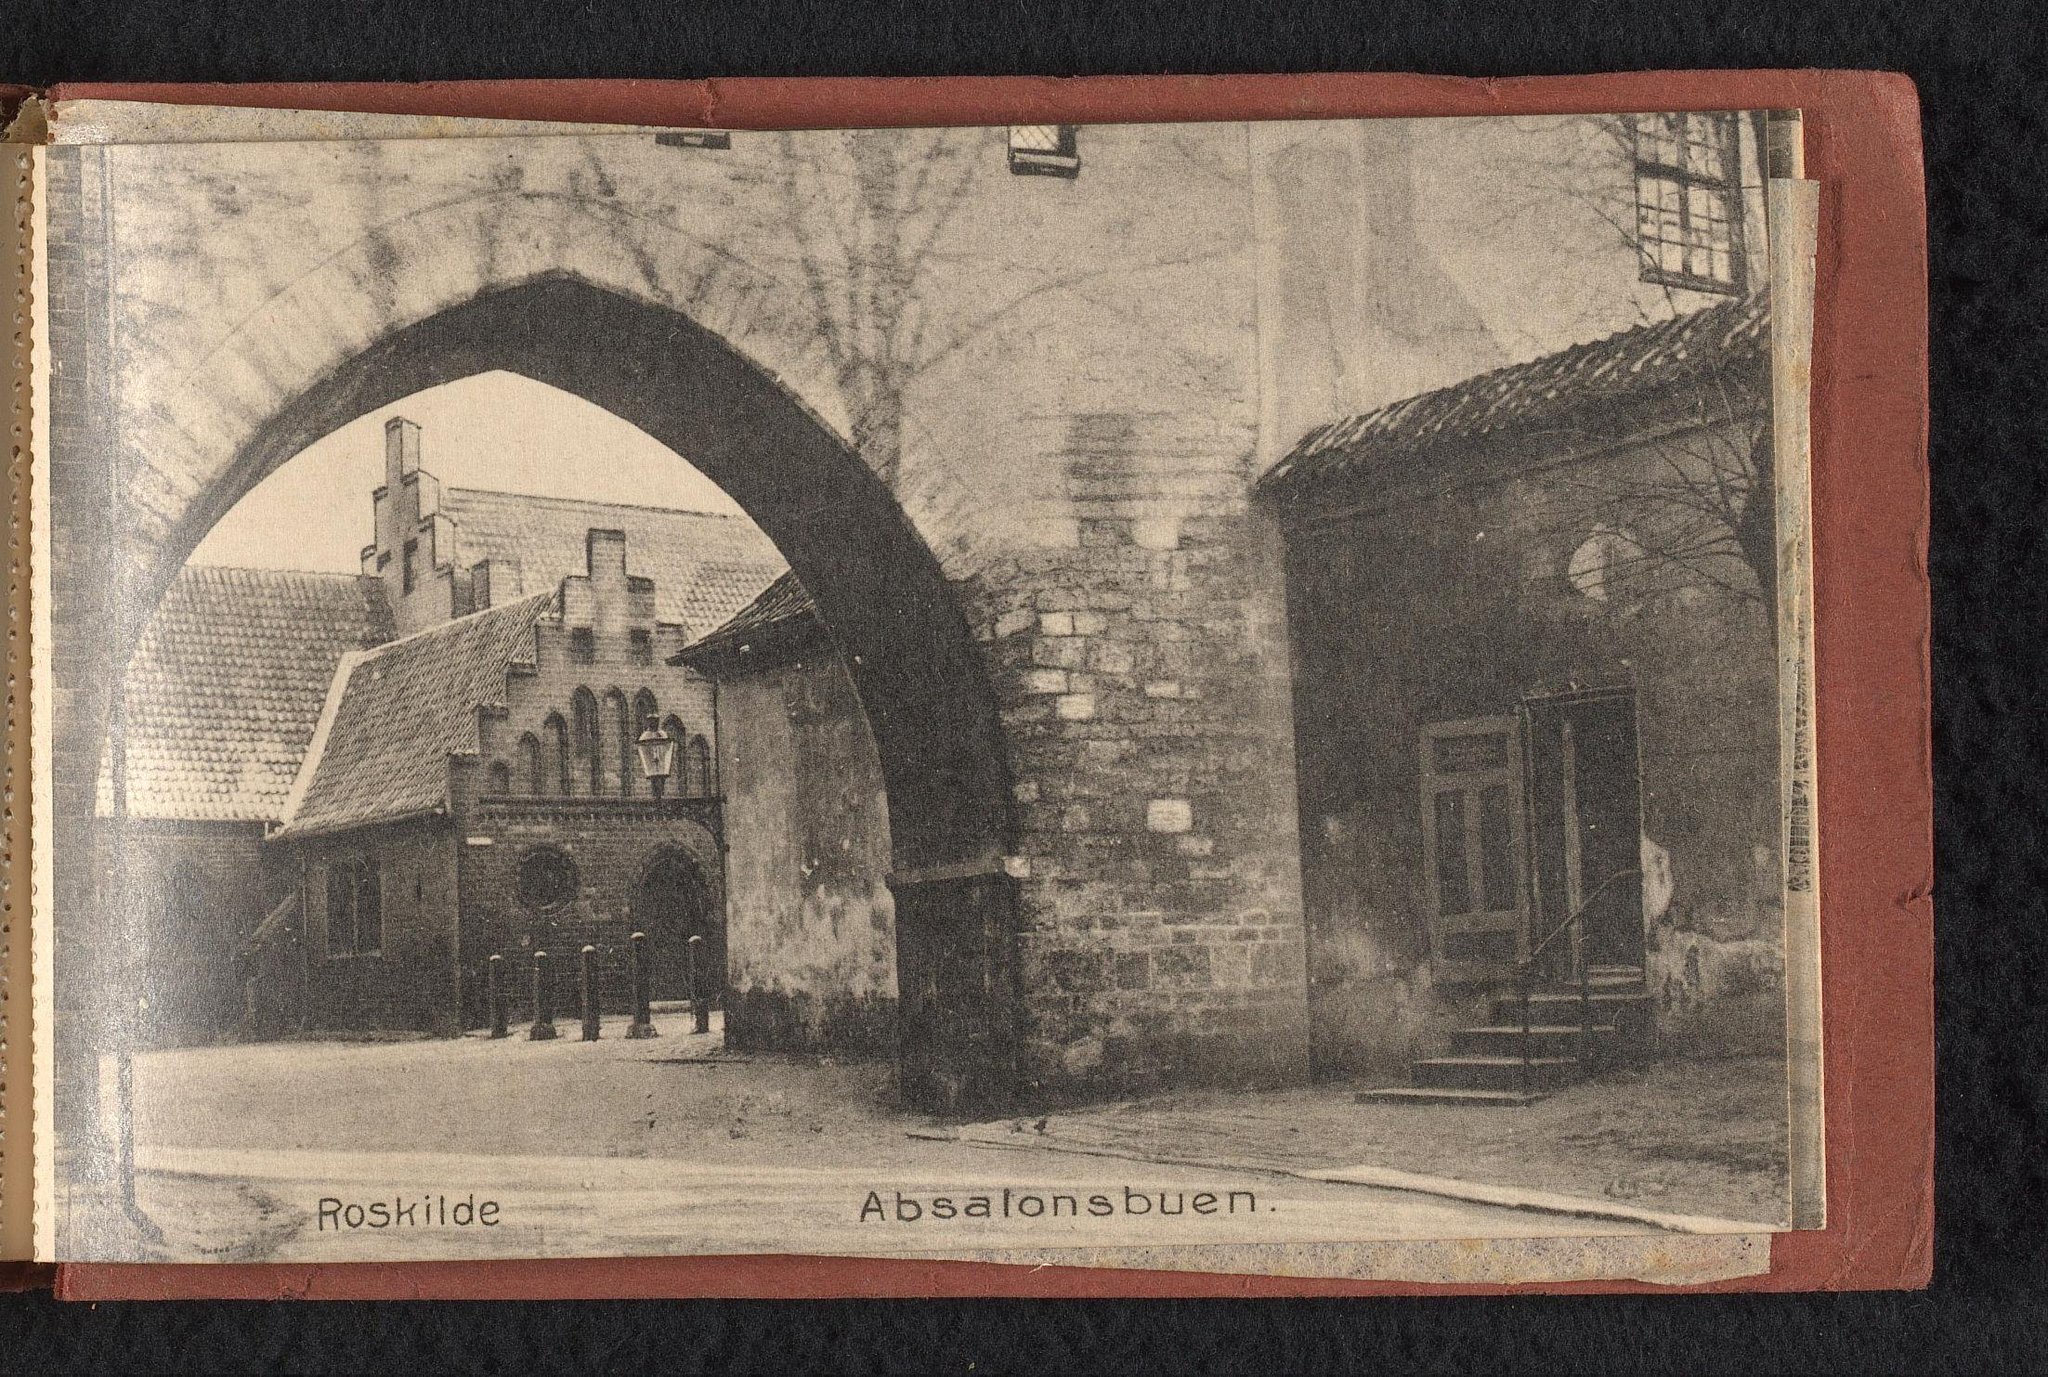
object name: ansichtkaart, prentbriefkaart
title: Roskilde Domkirke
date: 1906-1920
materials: cardboard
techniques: photograph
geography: roskilde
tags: city-view, and landscape with man-made constructions, arch, archivolt ~ architecture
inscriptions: mark: ‘CS’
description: Prentbriefkaart maakt deel uit van een album.